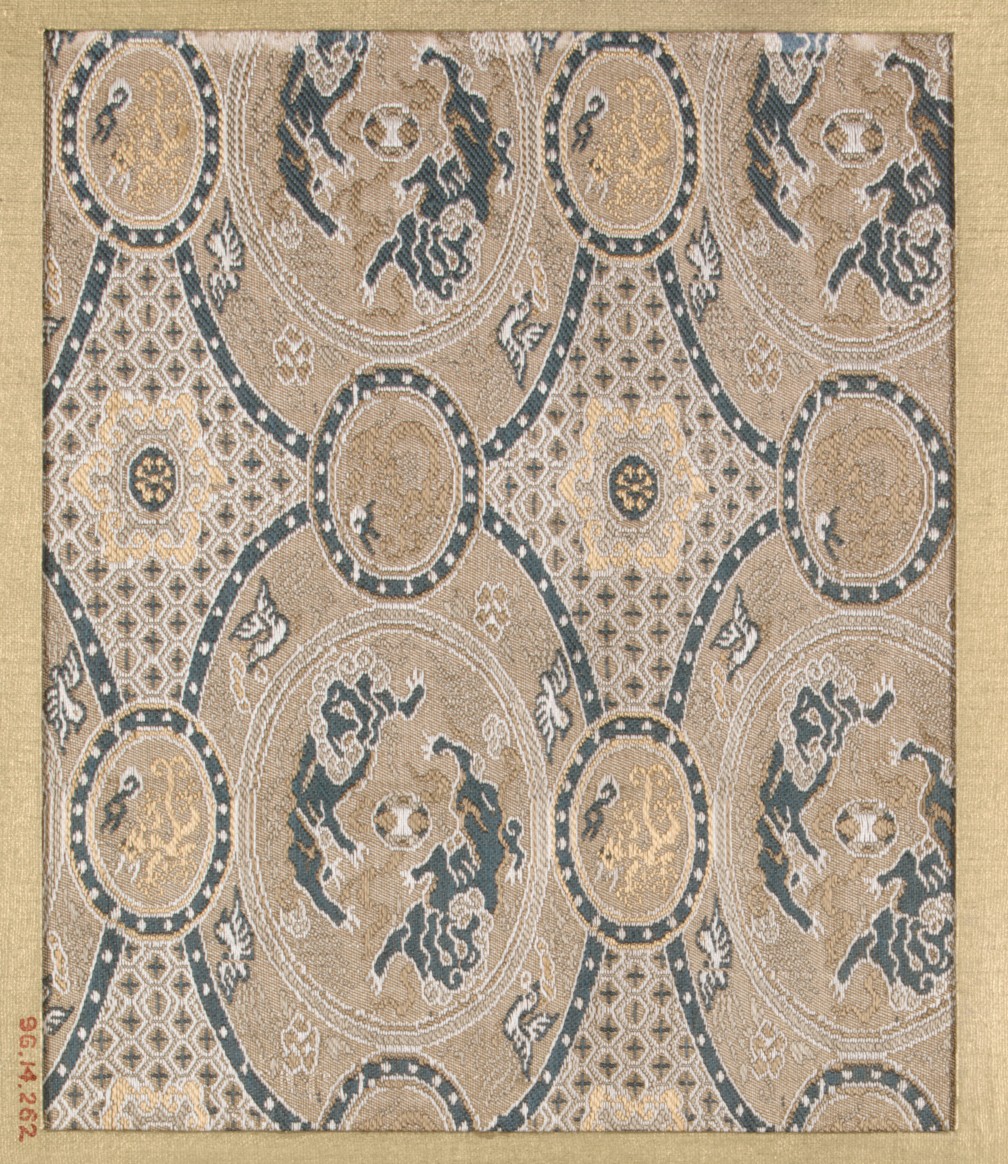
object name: piece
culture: japanese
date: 1701-1900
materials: silk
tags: birds,lions